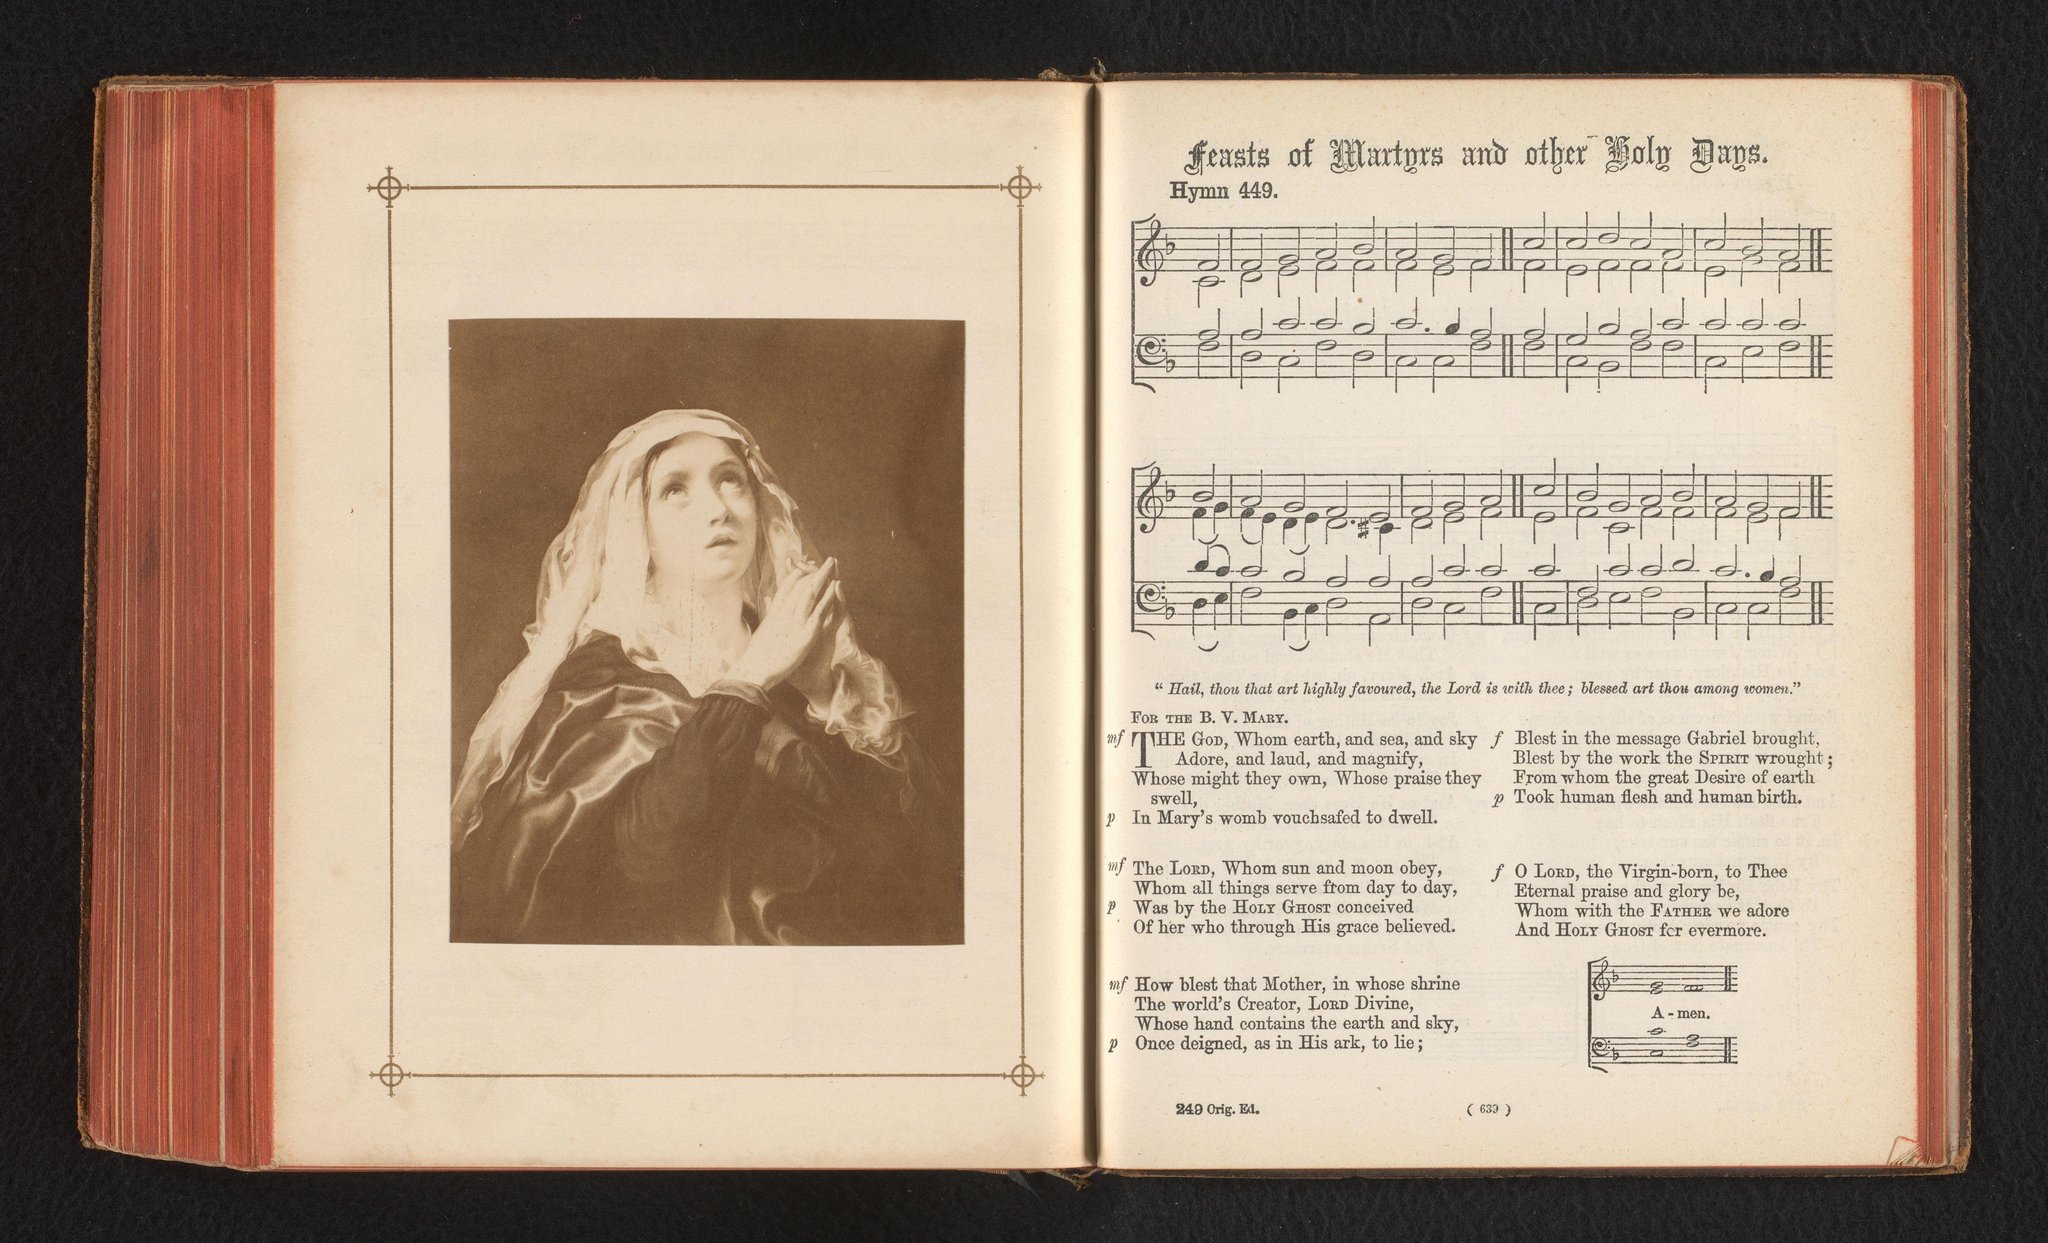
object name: photograph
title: Fotoreproductie van een schilderij van Maria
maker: Anonymous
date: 1866-1876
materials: paper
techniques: albumen print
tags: 'portraits' of mary, picture, painting